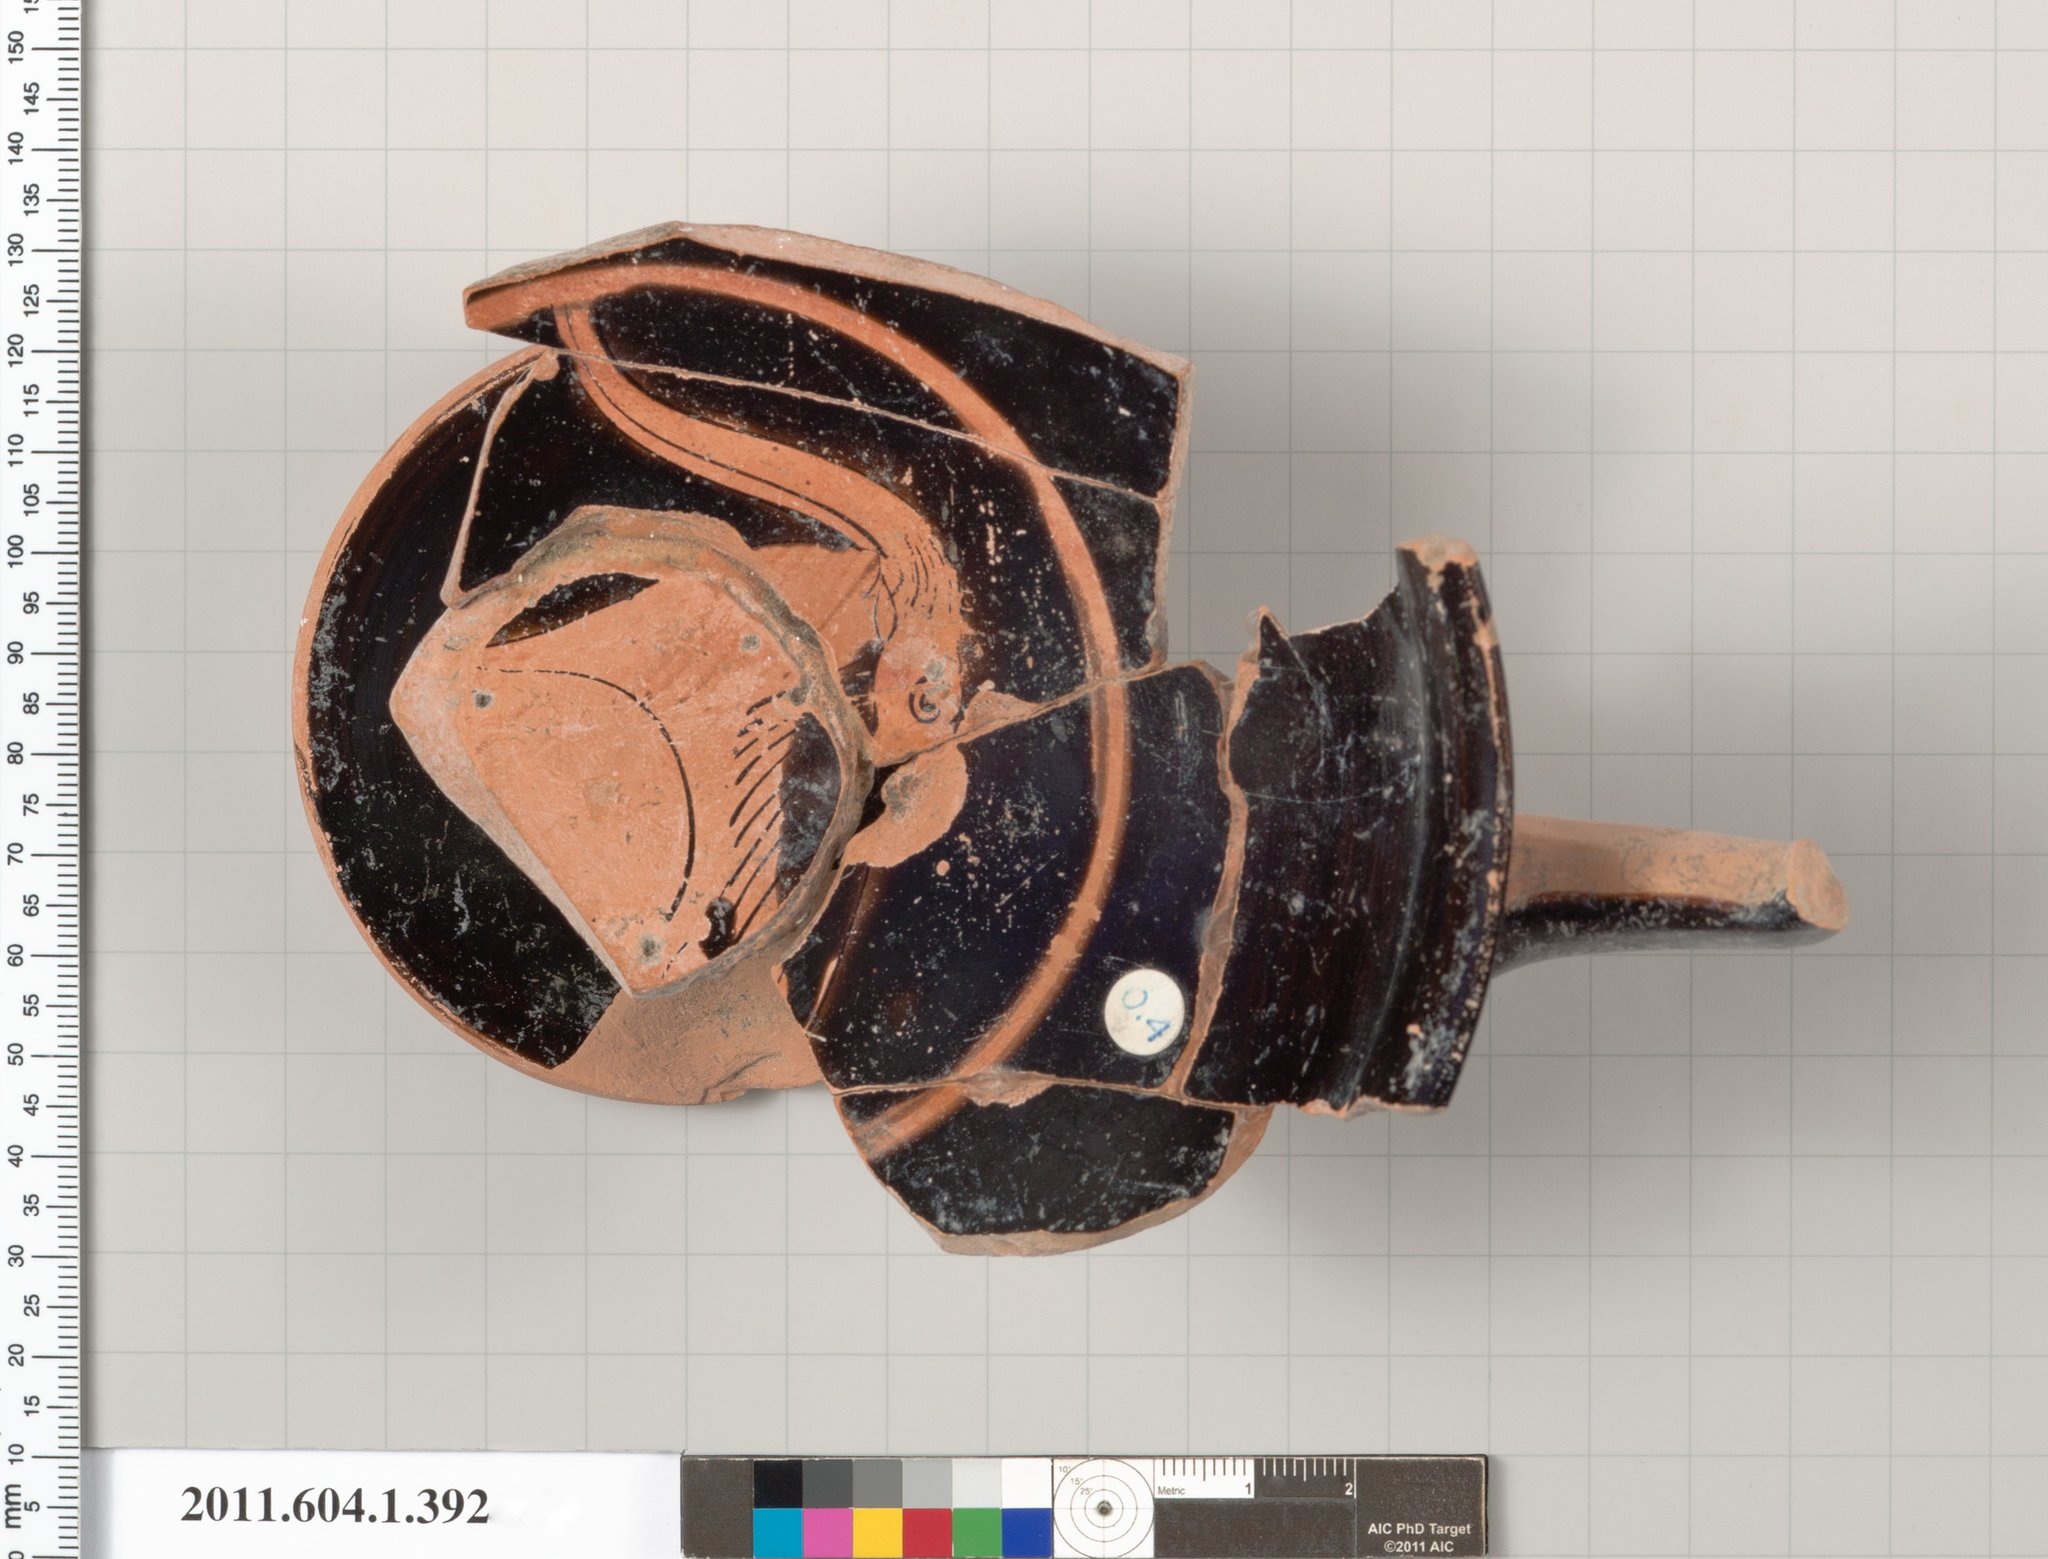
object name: kylix fragment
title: Terracotta fragments of a kylix (drinking cup)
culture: greek, attic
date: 500-476 BCE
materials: terracotta